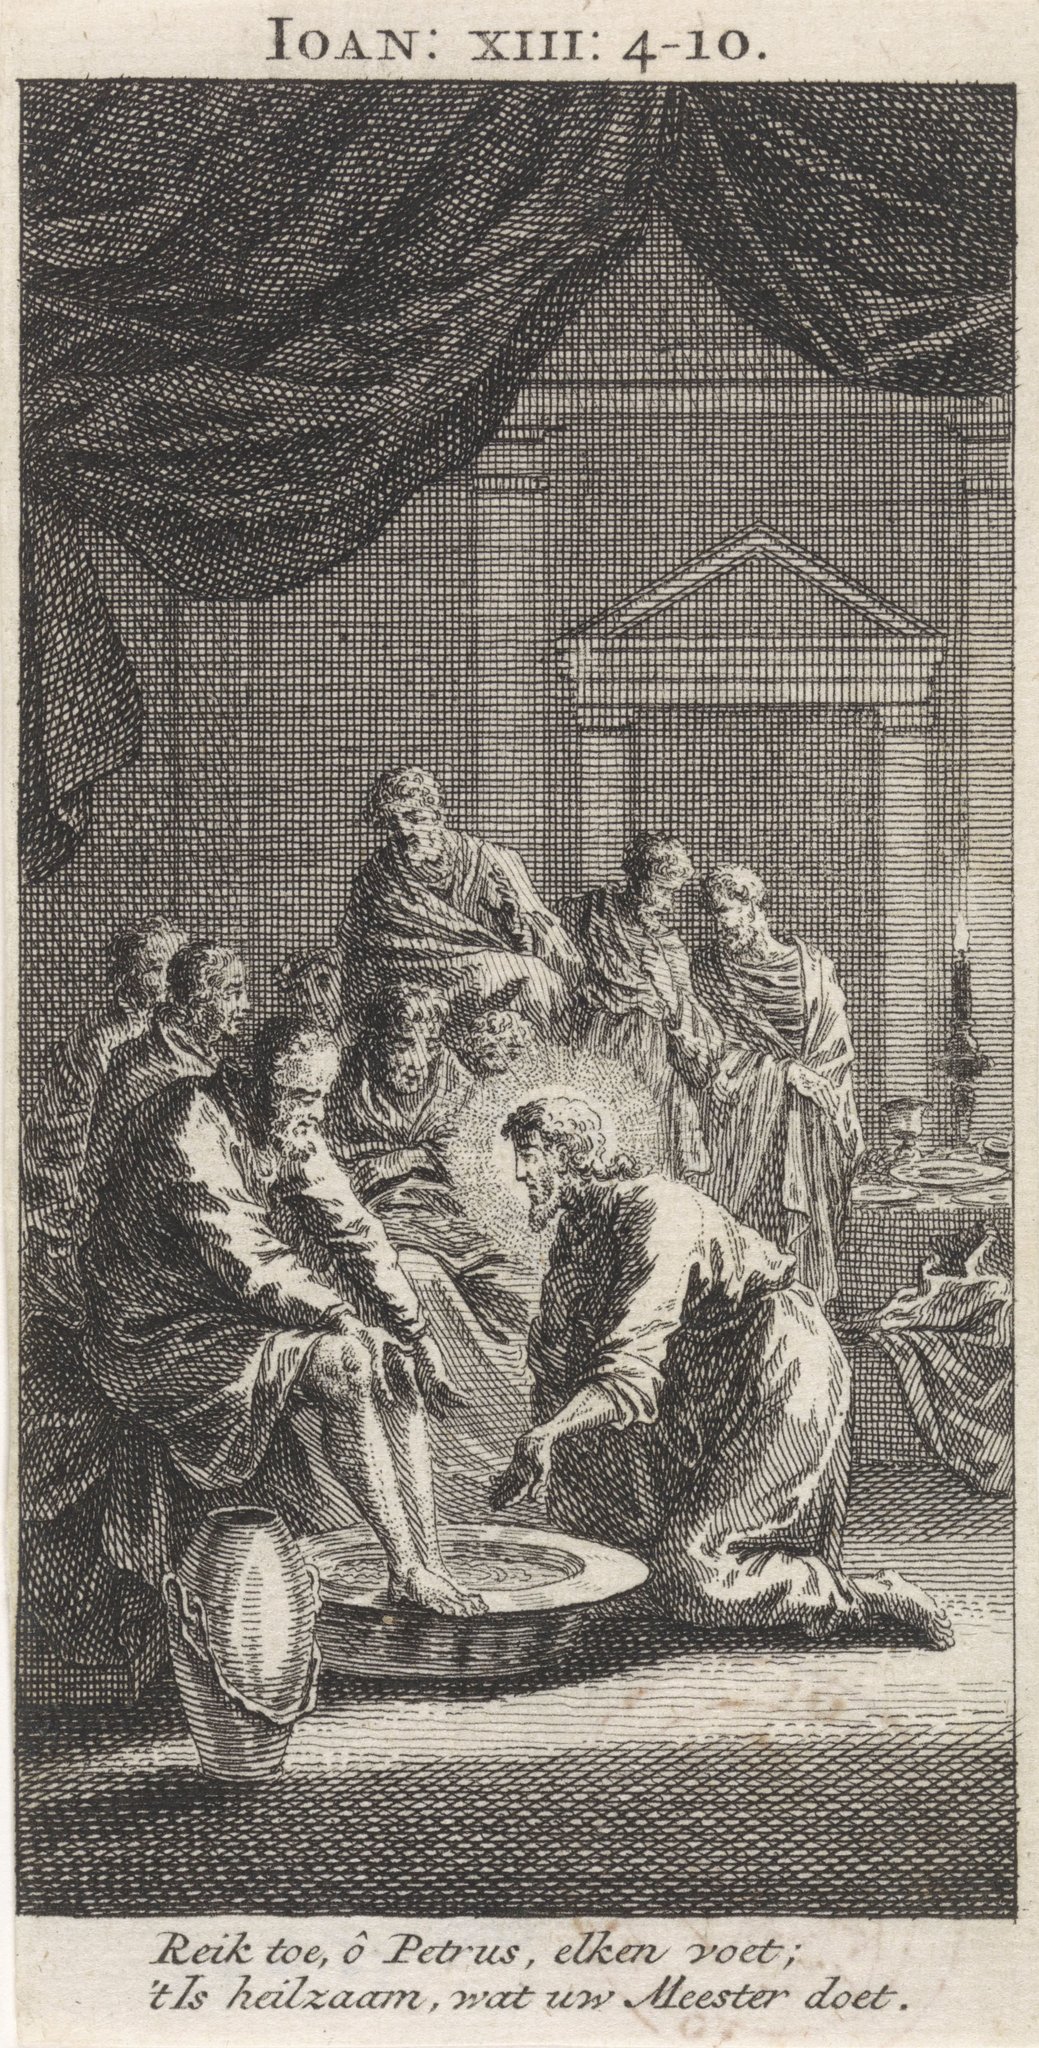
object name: print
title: Voetwassing van Petrus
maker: Anonymous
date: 1712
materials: paper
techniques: etching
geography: amsterdam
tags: christ washes peter's feet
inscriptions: collector's mark: Lugt 240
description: Kopie van illustratie voor: Luyken, Jan. Bybel printen. Amsterdam: Pieter Arentsz. II (wed.) en Cornelis van der Sys, 1712, p. 33.